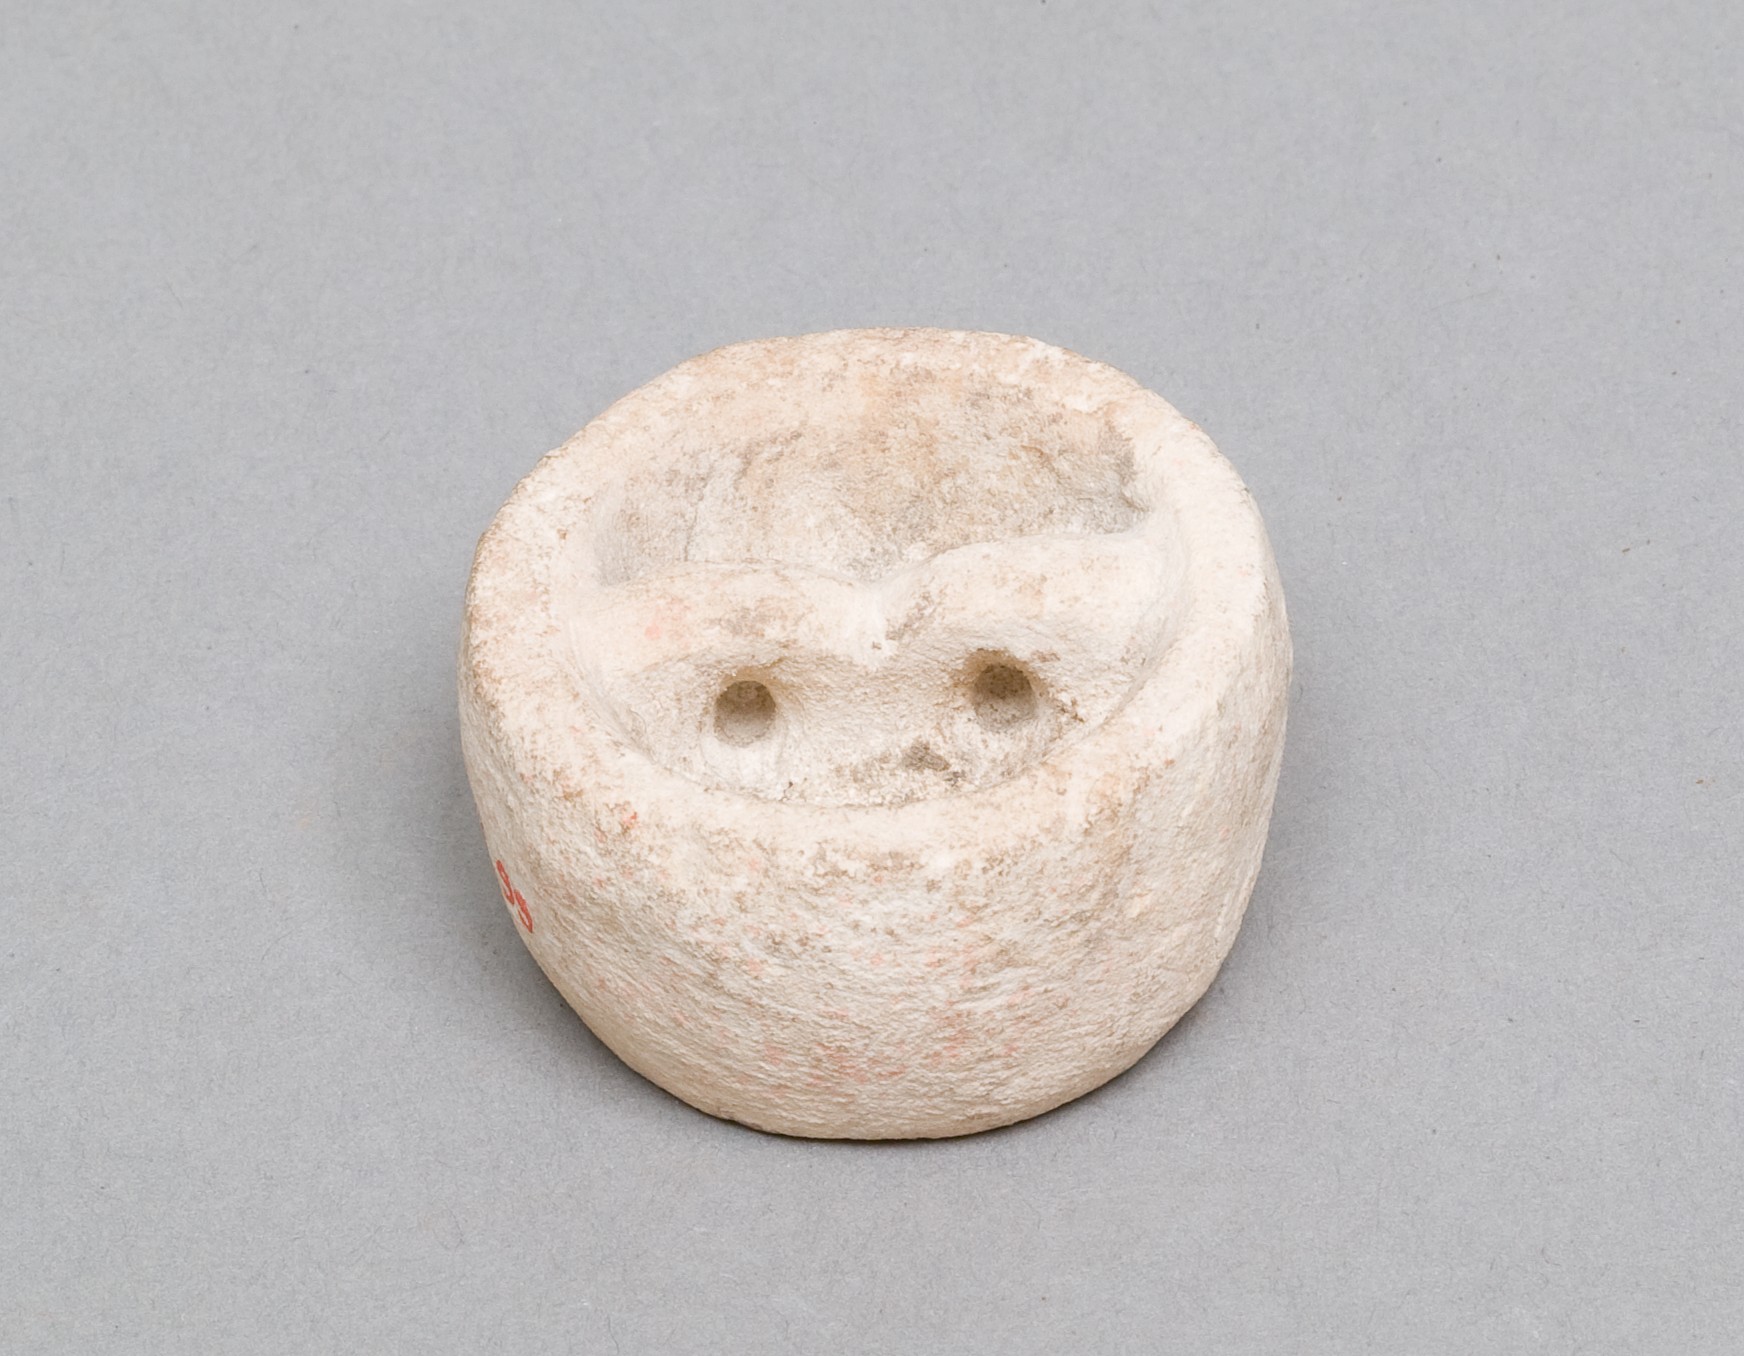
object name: miniature spinning bowl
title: Model of spinning bowl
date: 1850-1800 BCE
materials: limestone, paint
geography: egypt